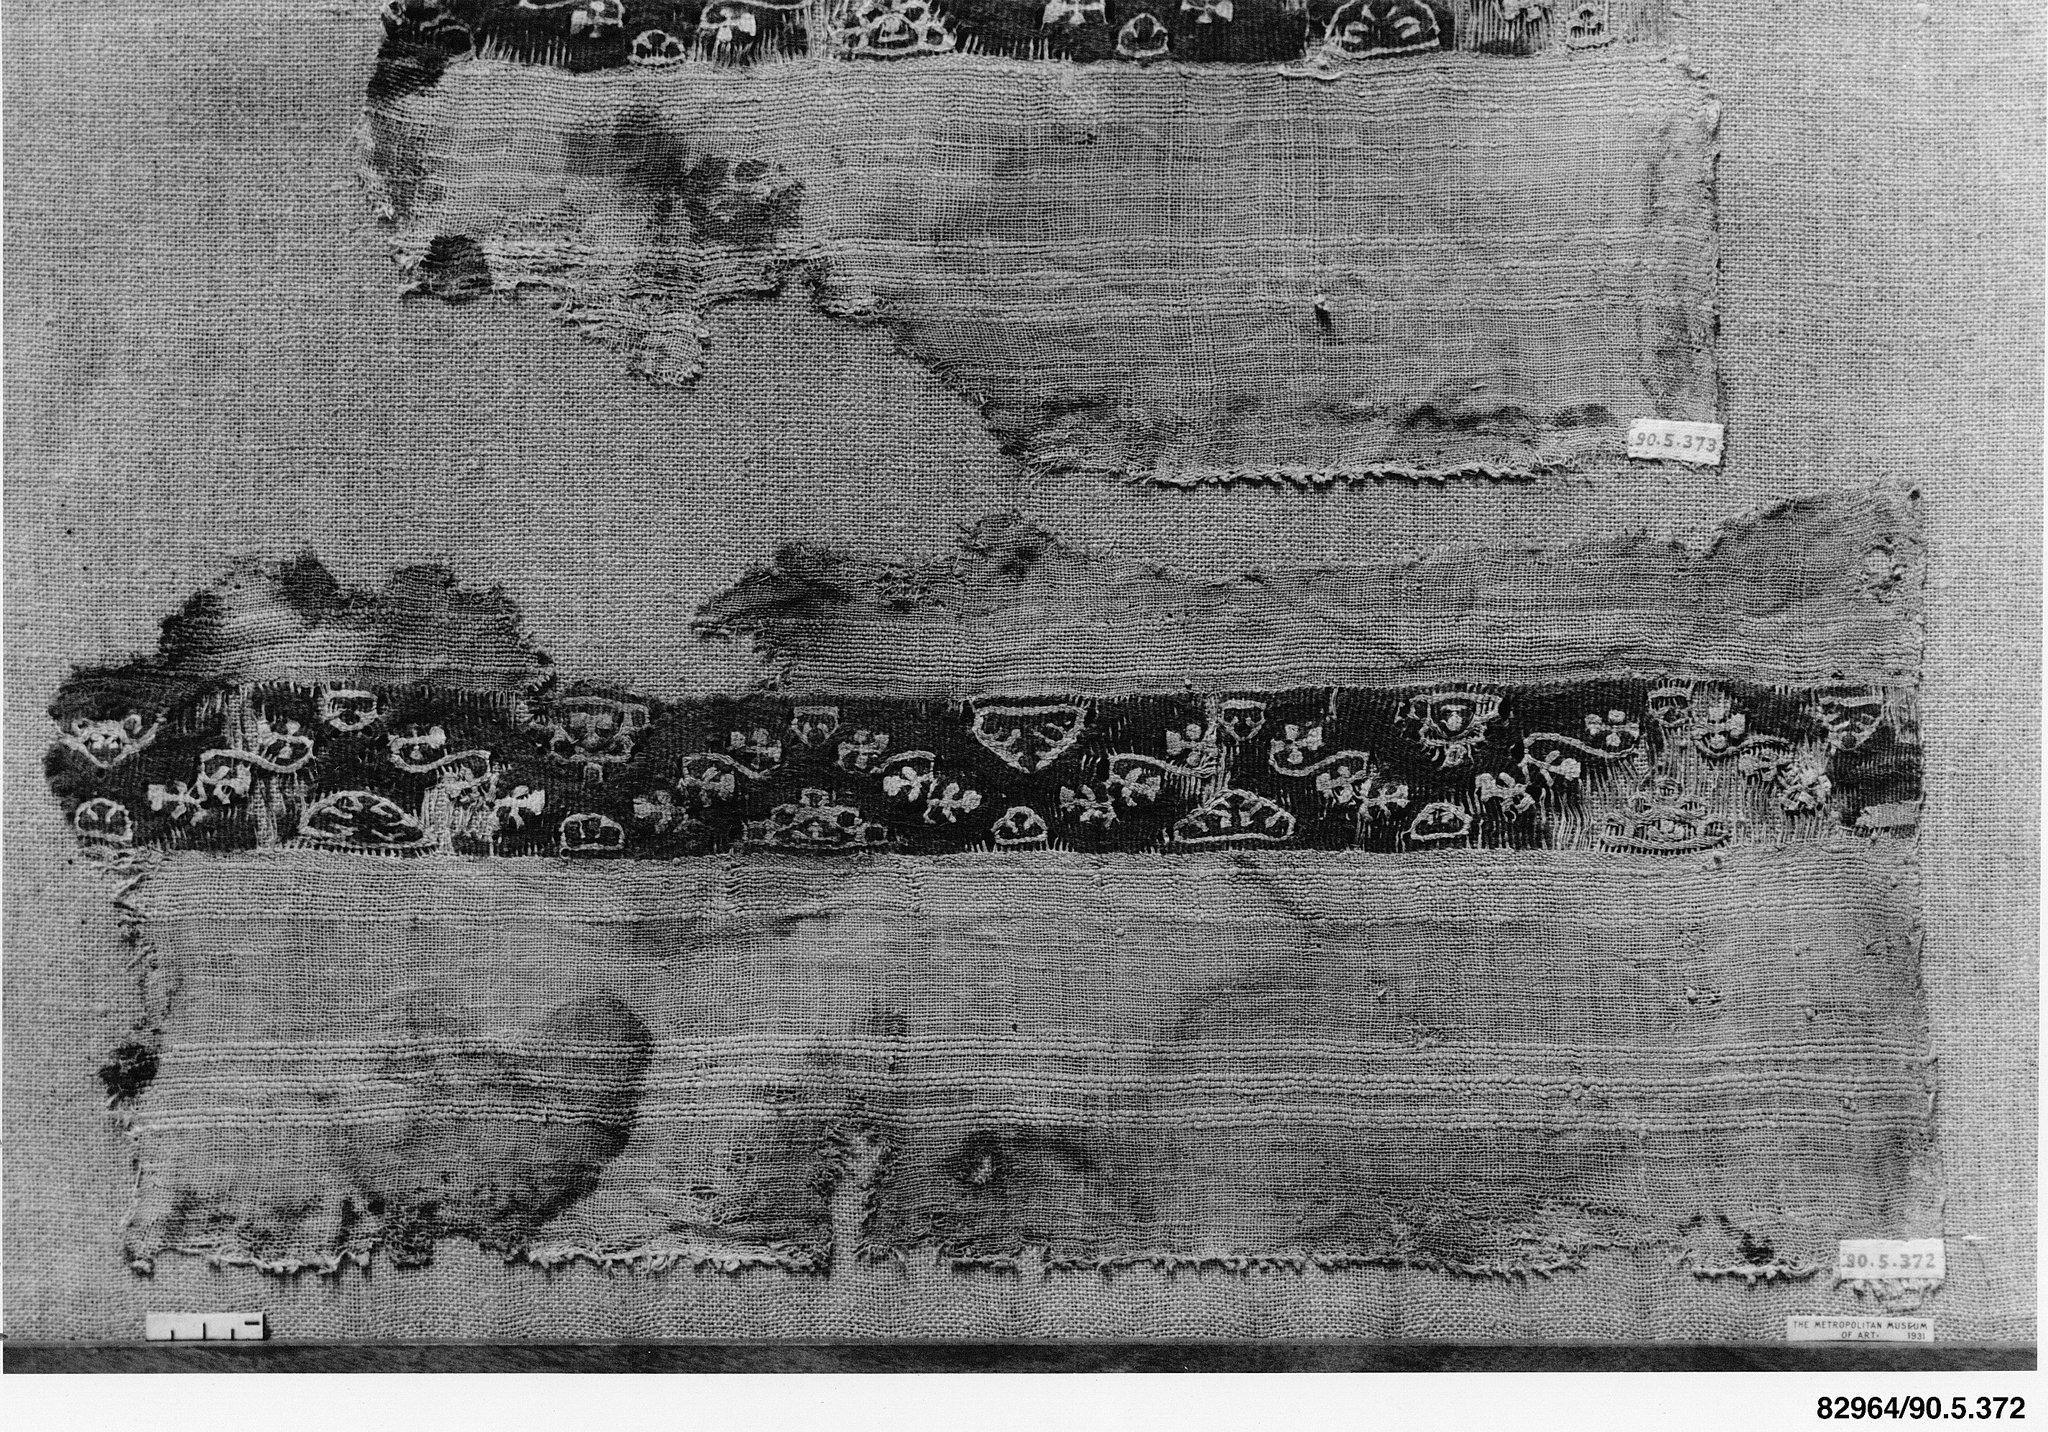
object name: textile fragment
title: Fragment of a Tunic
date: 401-600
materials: linen, wool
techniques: weave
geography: egypt